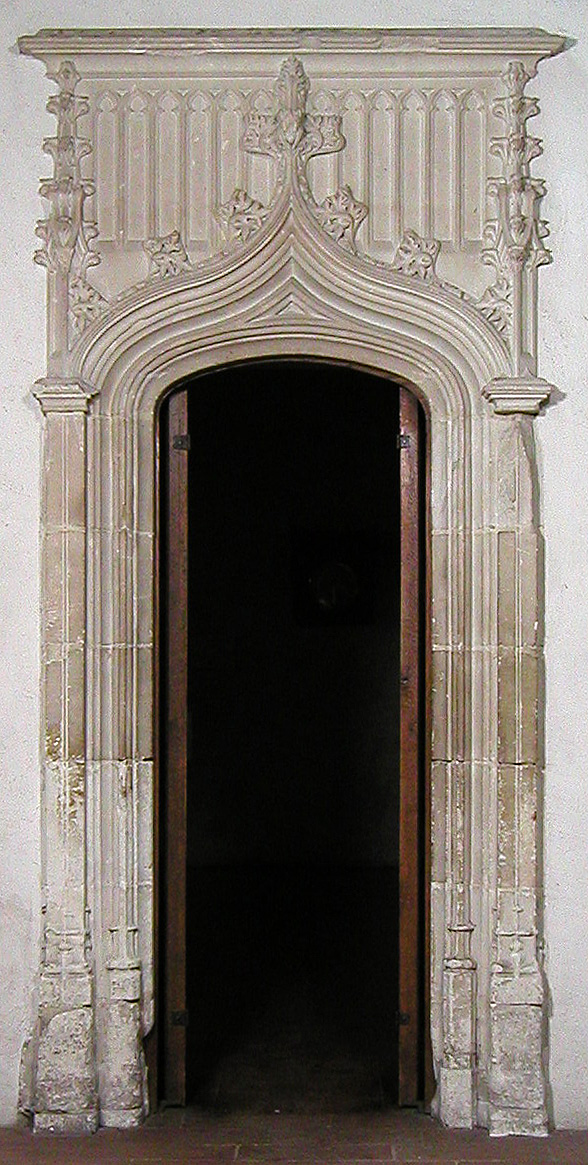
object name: doorway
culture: french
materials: limestone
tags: doorways